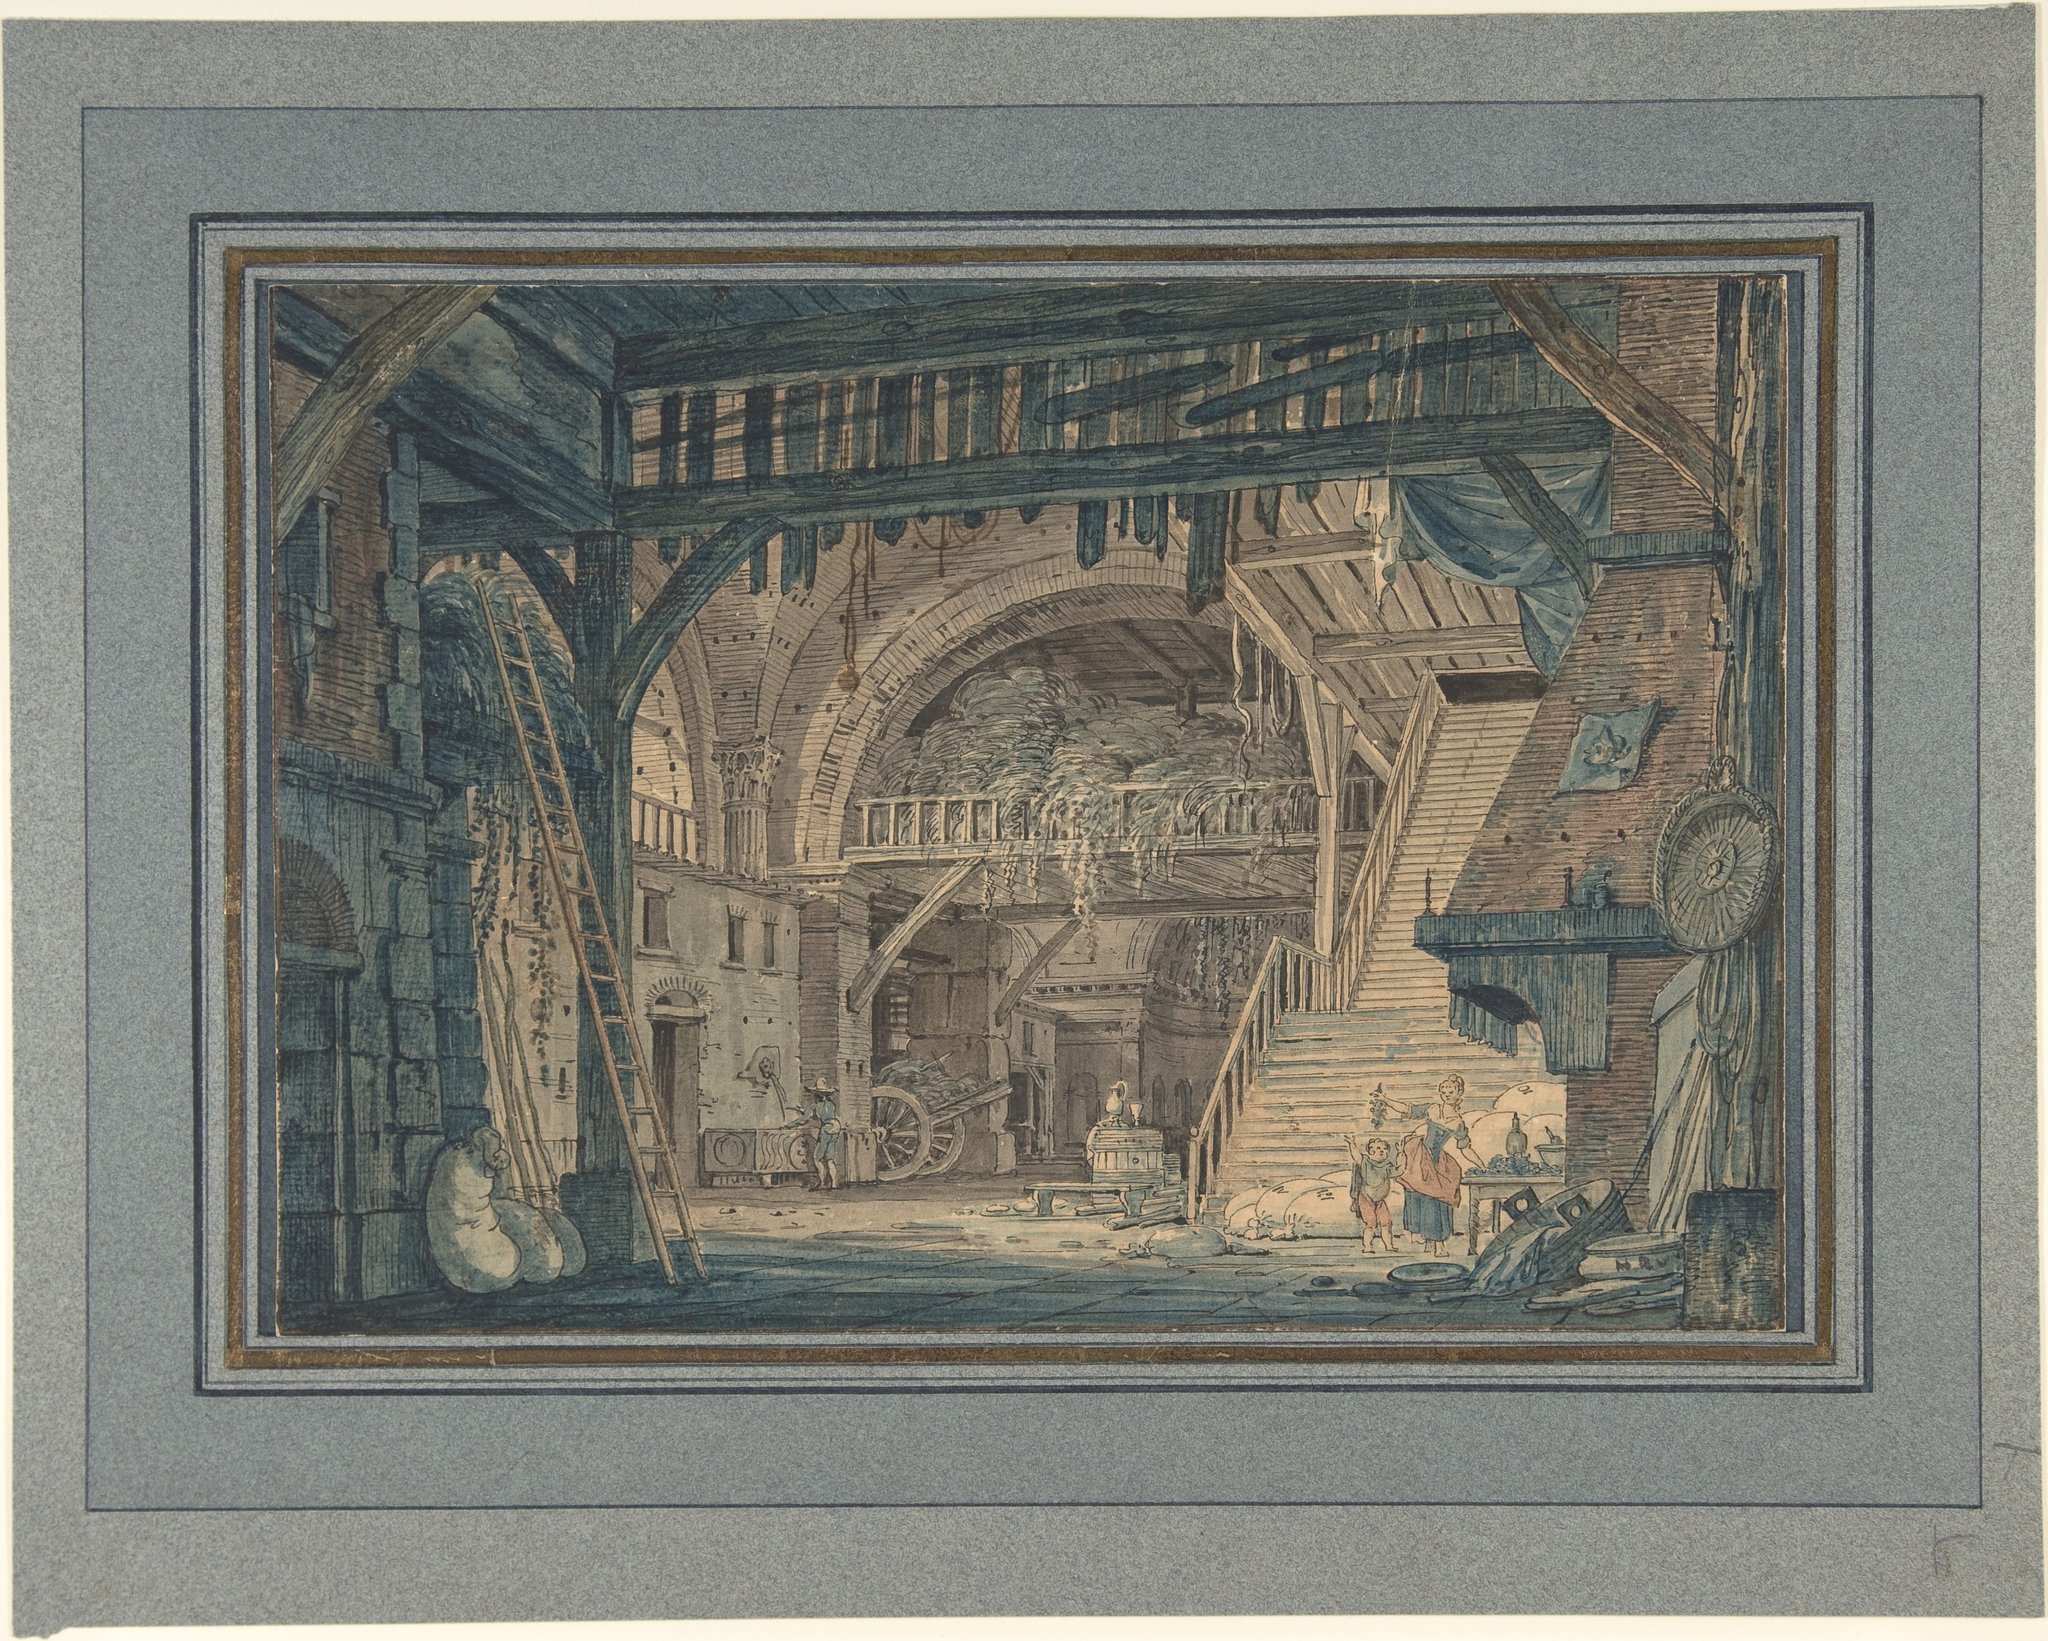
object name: drawing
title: Stage Set Design of an Ancient Roman Ruin being Converted into a Barn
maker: johann heinrich ramberg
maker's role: artist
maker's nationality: german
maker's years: 1763-1840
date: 1767-1866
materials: ink, watercolor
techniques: pen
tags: theatre,stage design